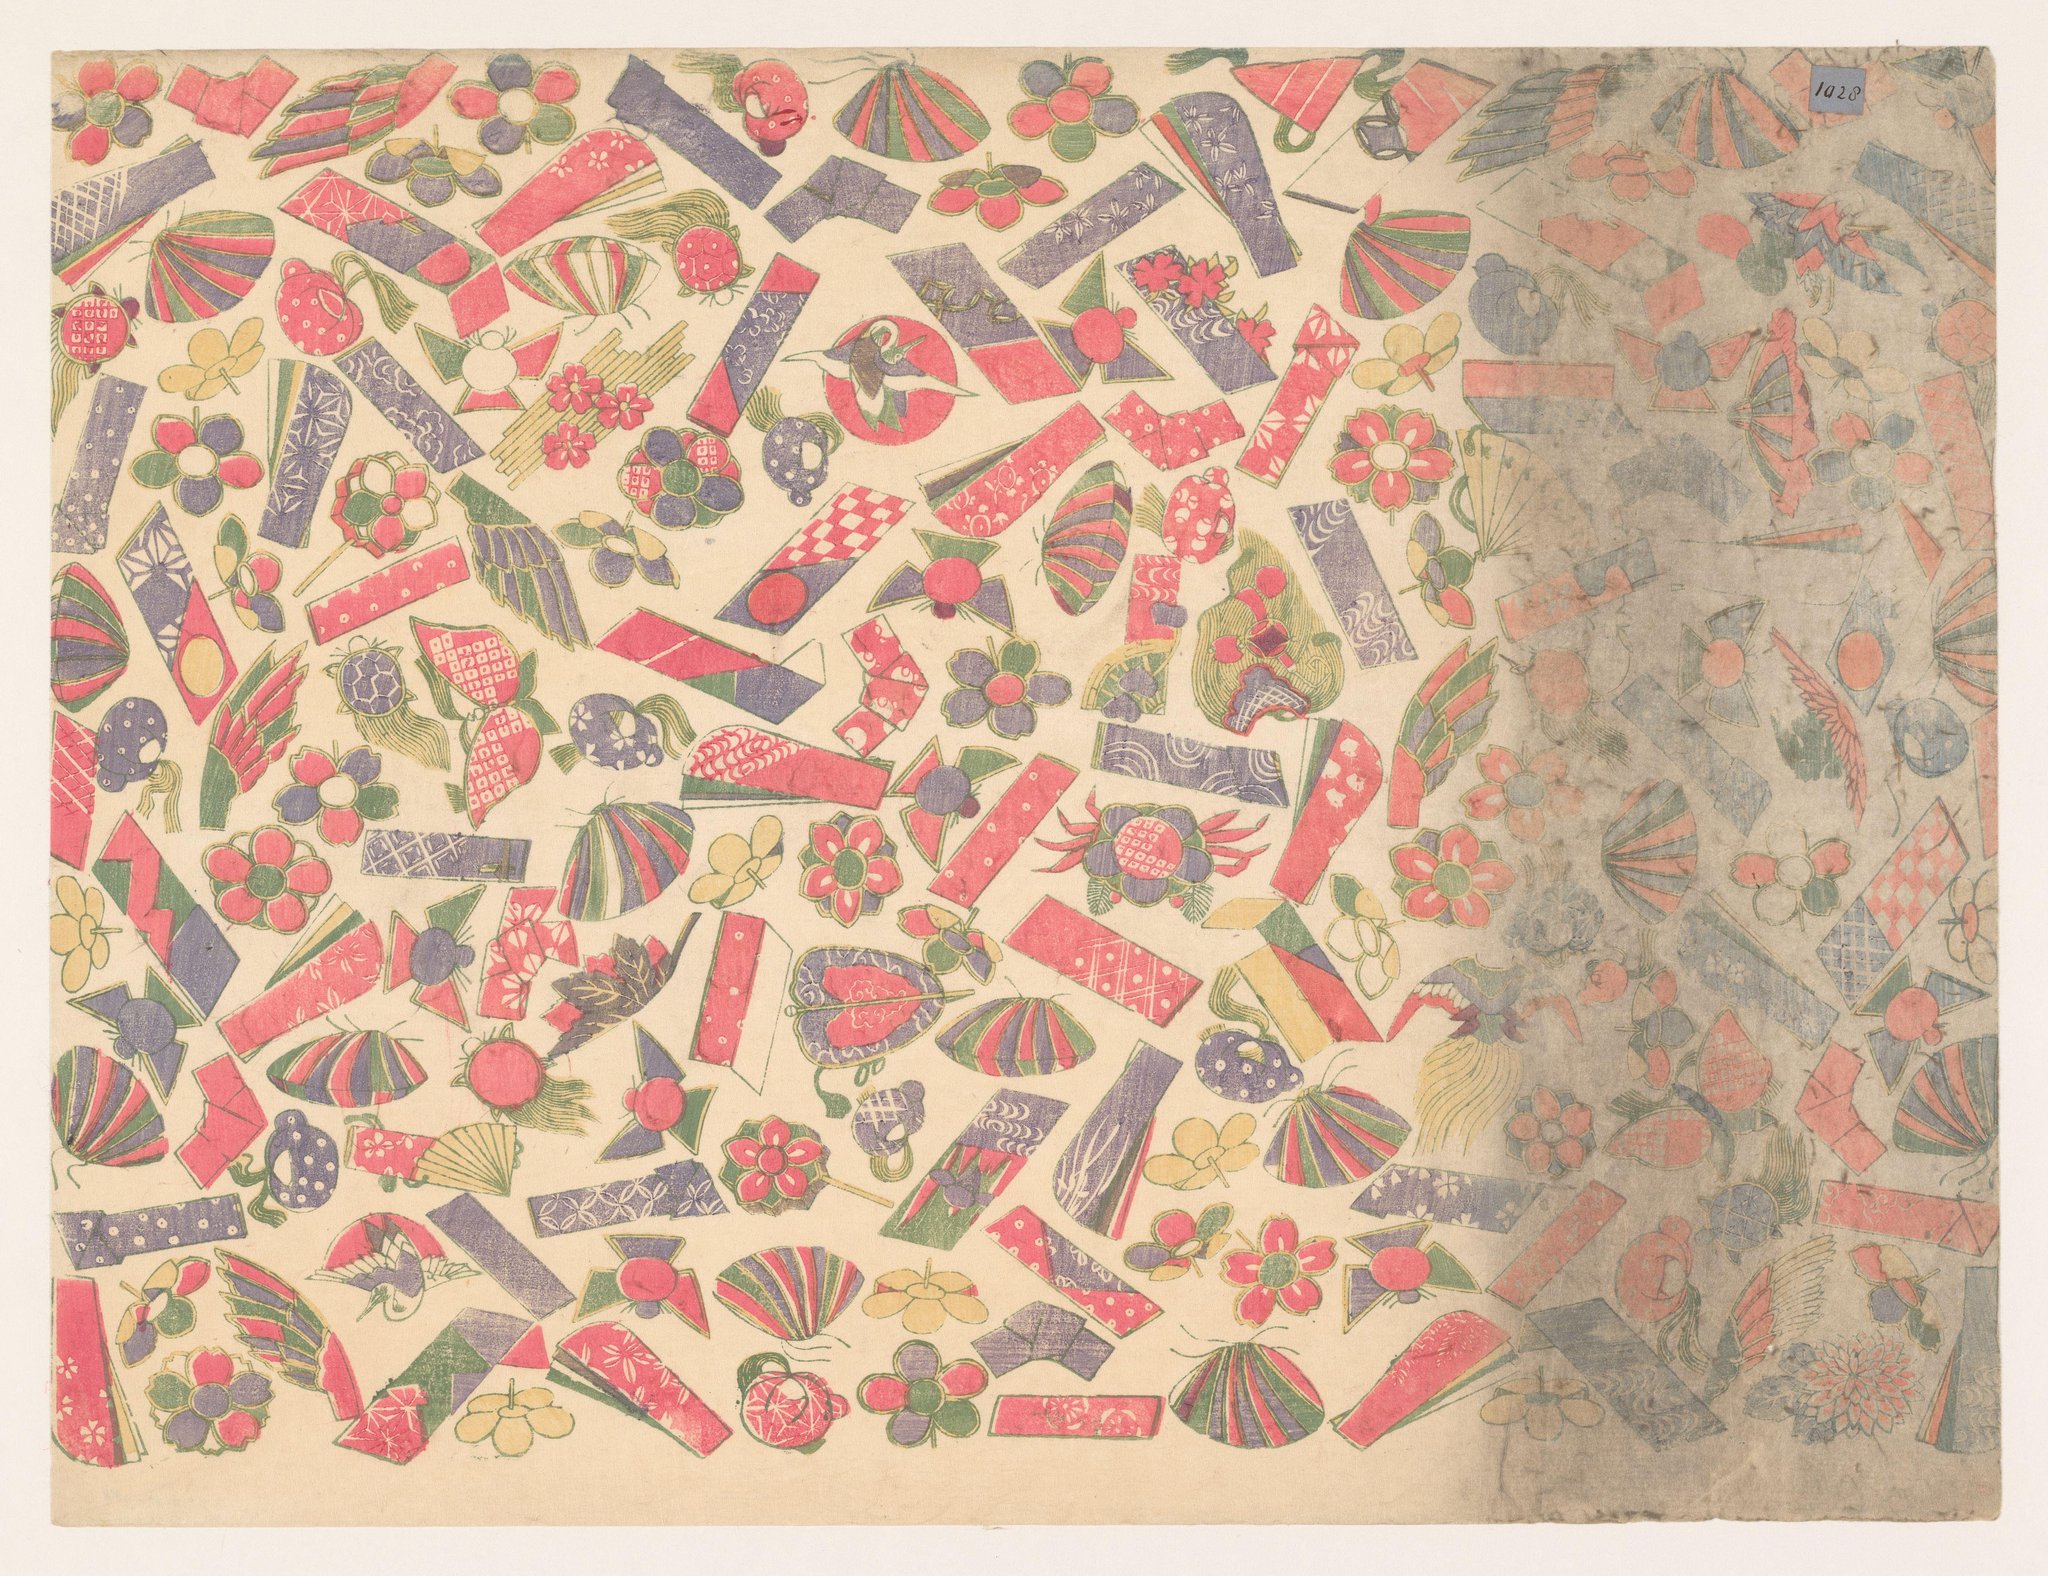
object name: decorated paper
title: Patroon van geluksvoorwerpen (speelgoed, waaiers en vliegers)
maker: Anonymous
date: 1860-1930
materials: paper, paint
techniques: woodcut, printing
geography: japan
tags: ornament derived from objects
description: Patroon van geluksvoorwerpen (speelgoed, waaiers en vliegers). Rechterzijde sterk vervuild en verkleurd, rechtsboven etiket waarop geschreven: 1028.